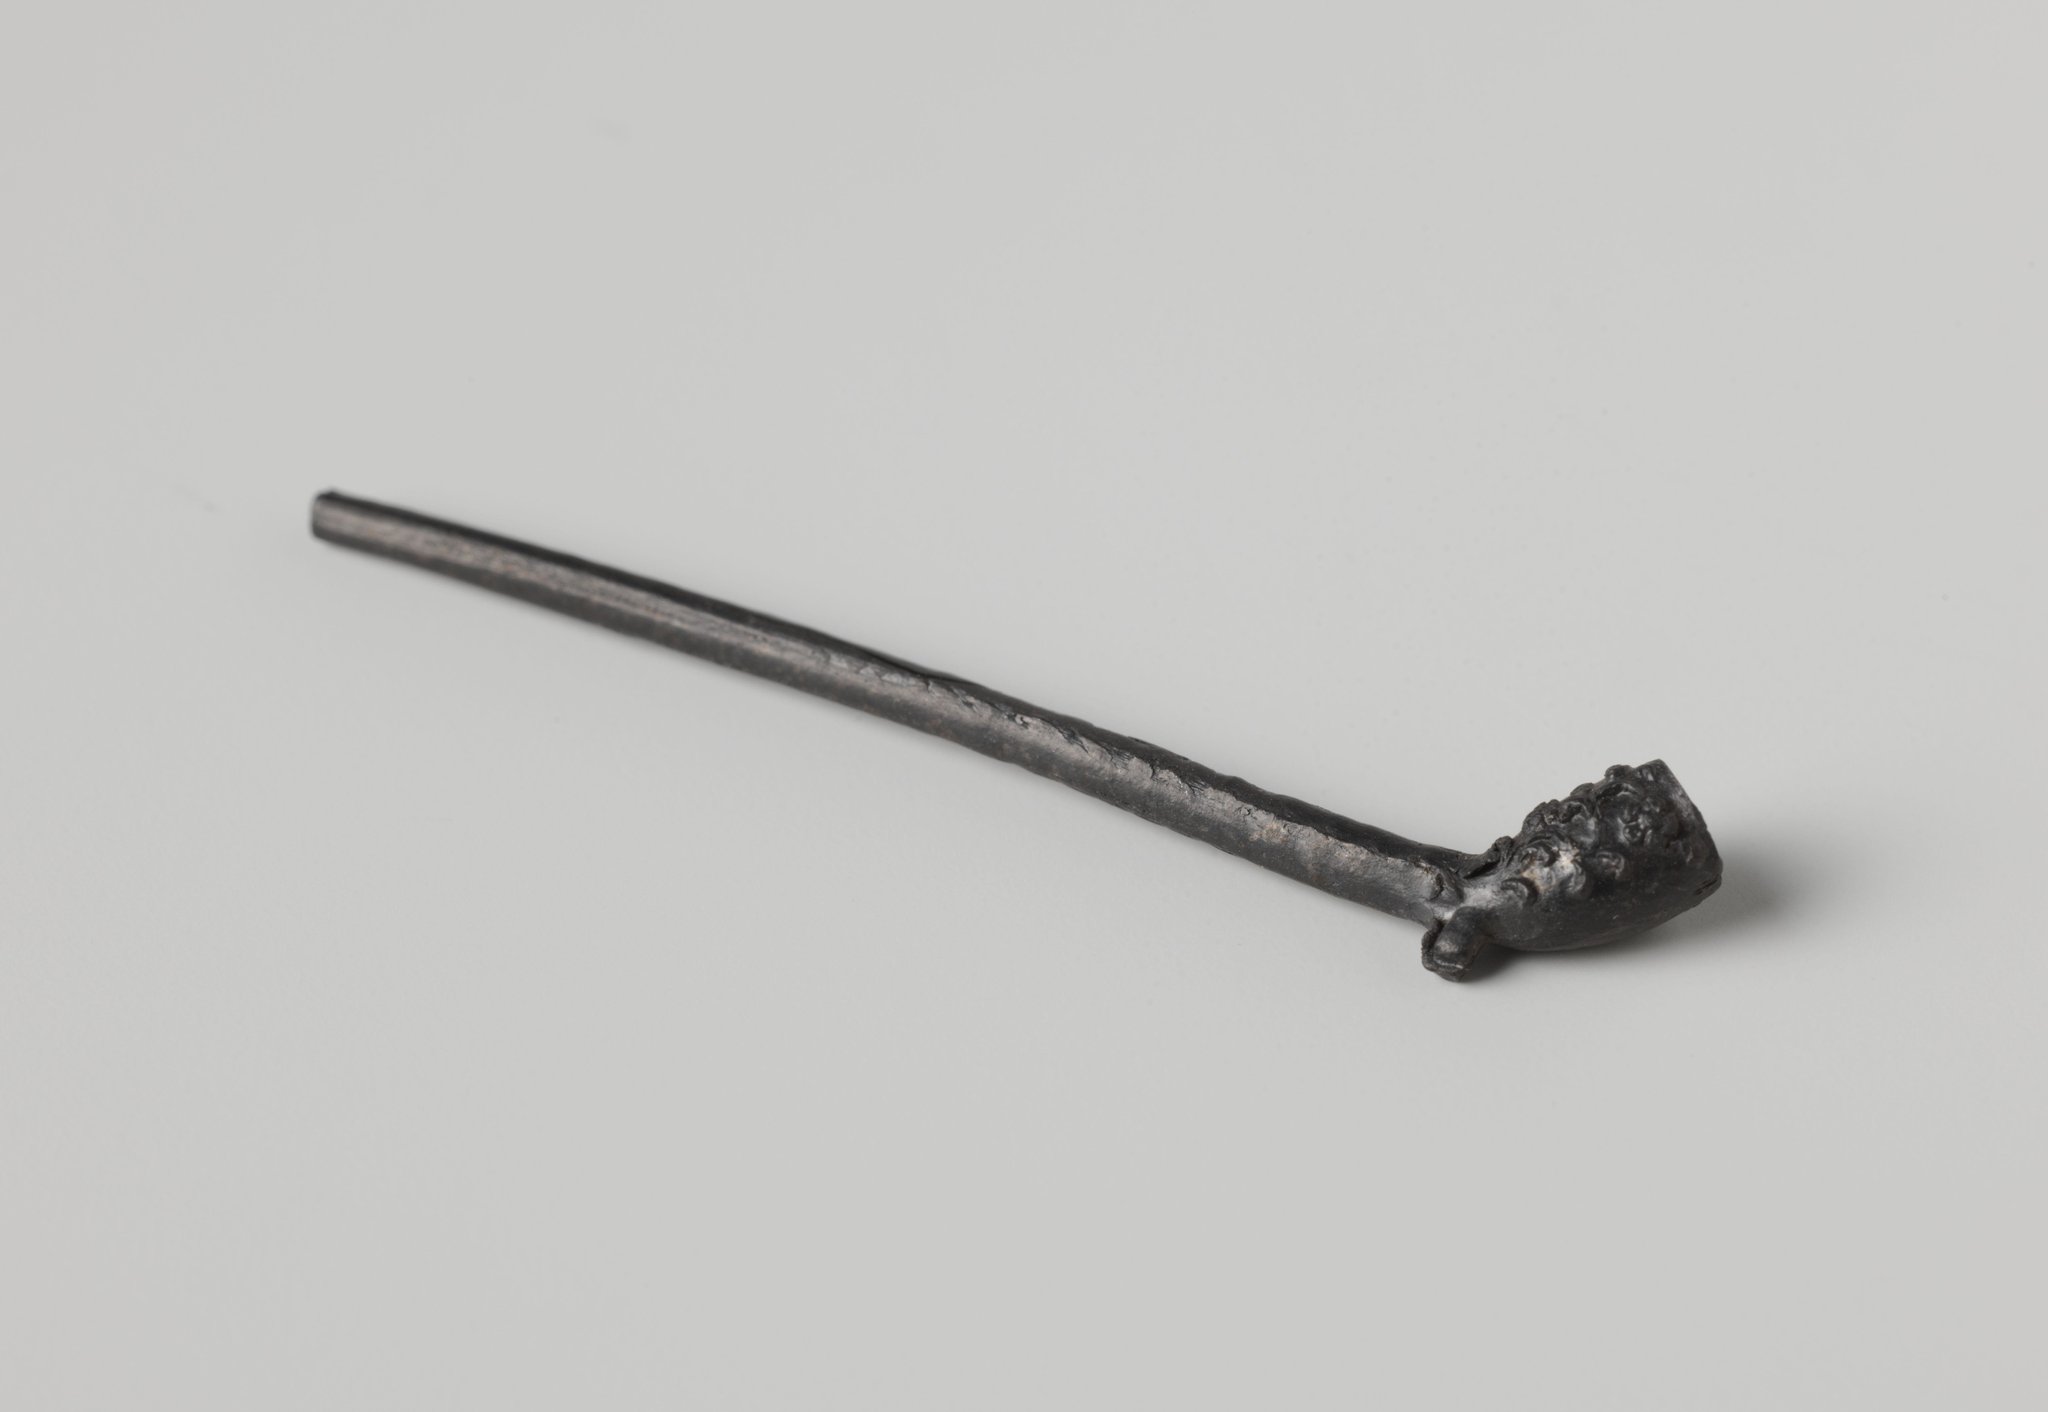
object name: miniature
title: Pijp van zwarte pijpaarde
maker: Anonymous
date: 1700-1799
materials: clay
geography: gouda